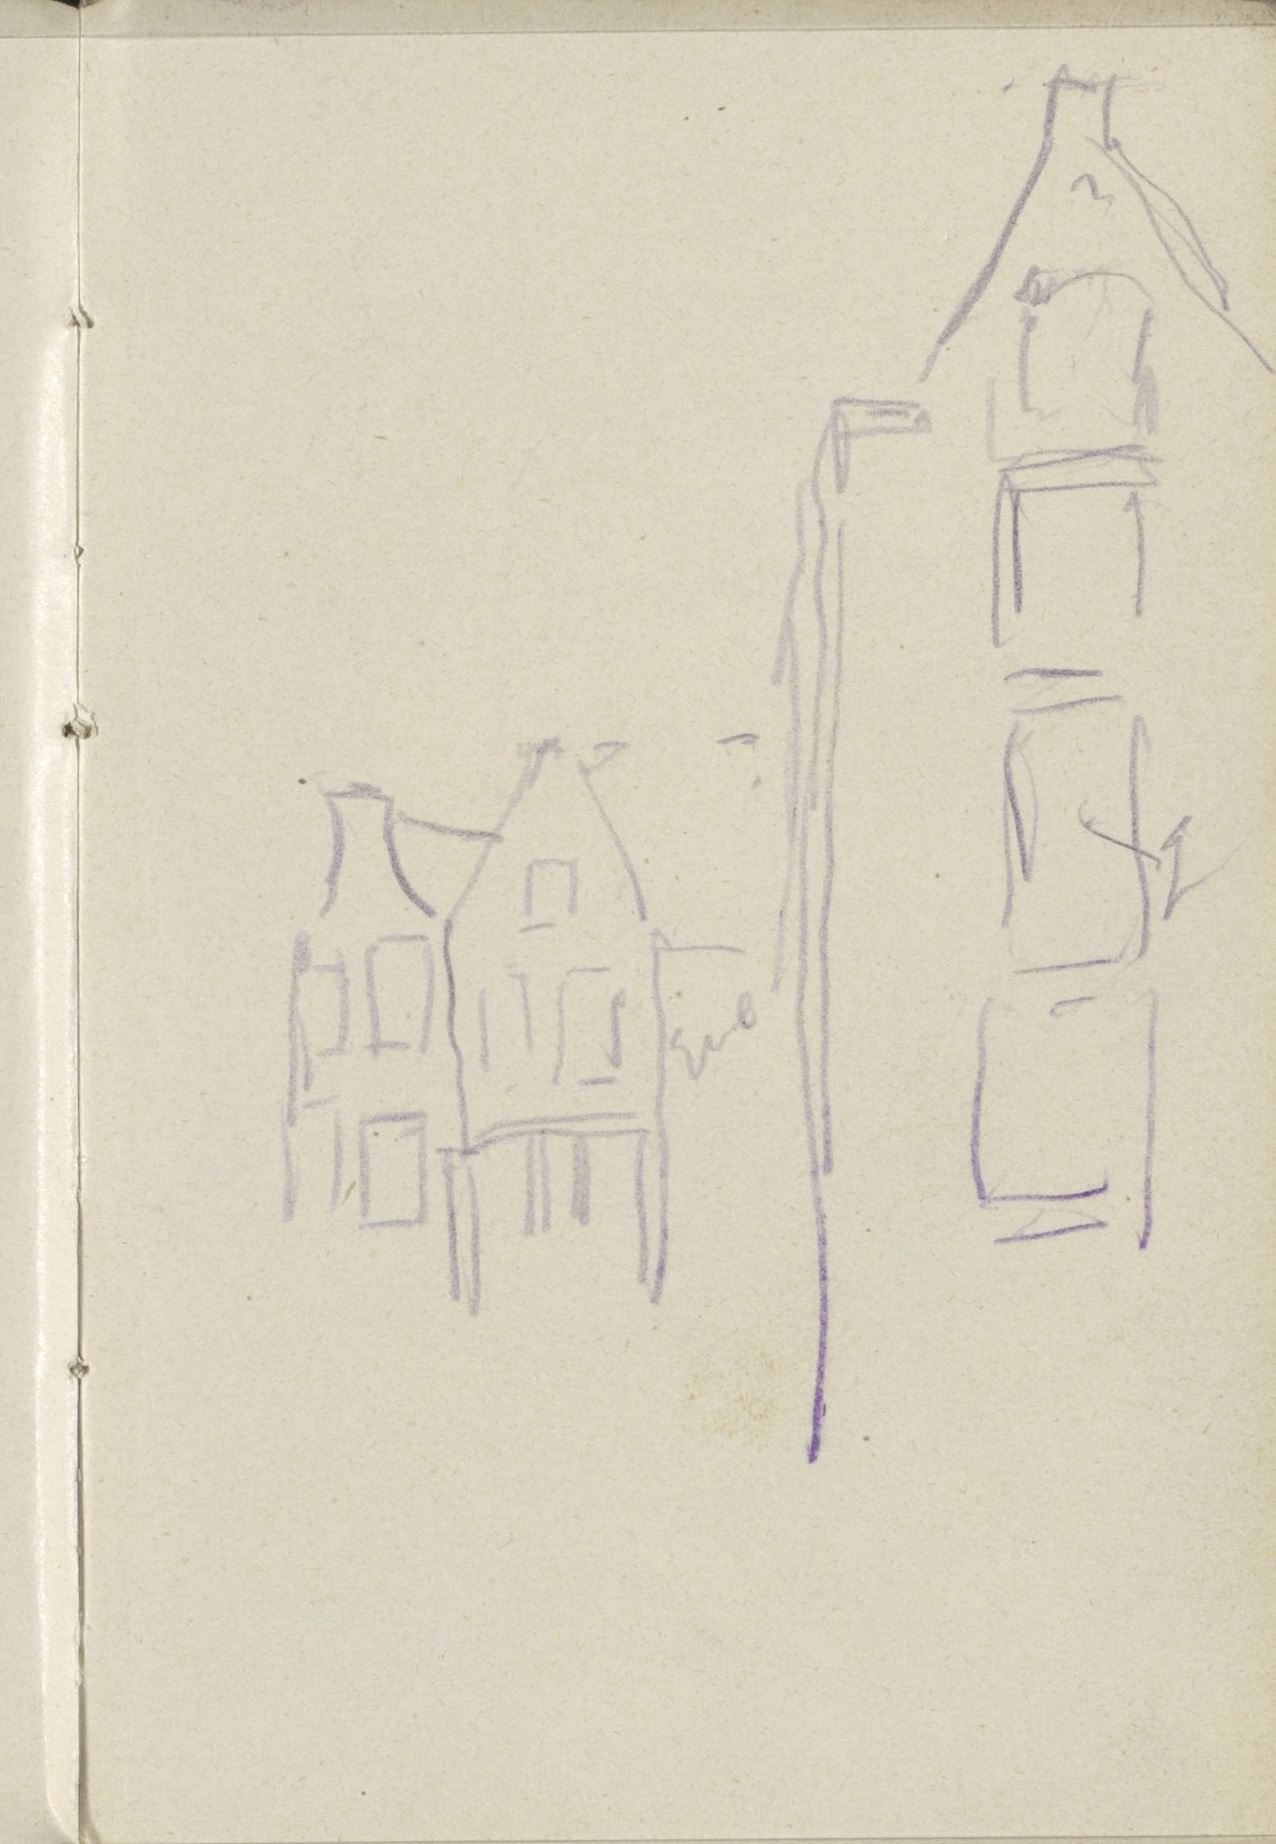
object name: sketchbook leaf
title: Gezicht op gebouwen, mogelijk in Amsterdam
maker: george hendrik breitner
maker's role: draughtsman, painter, print maker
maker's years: 1857-1923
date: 1915-1916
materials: paper, pencil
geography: amsterdam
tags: civic architecture; edifices; dwellings, amsterdam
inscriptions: kleurnotitie, handgeschreven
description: Pagina 6 uit een schetsboek met 43 bladen.